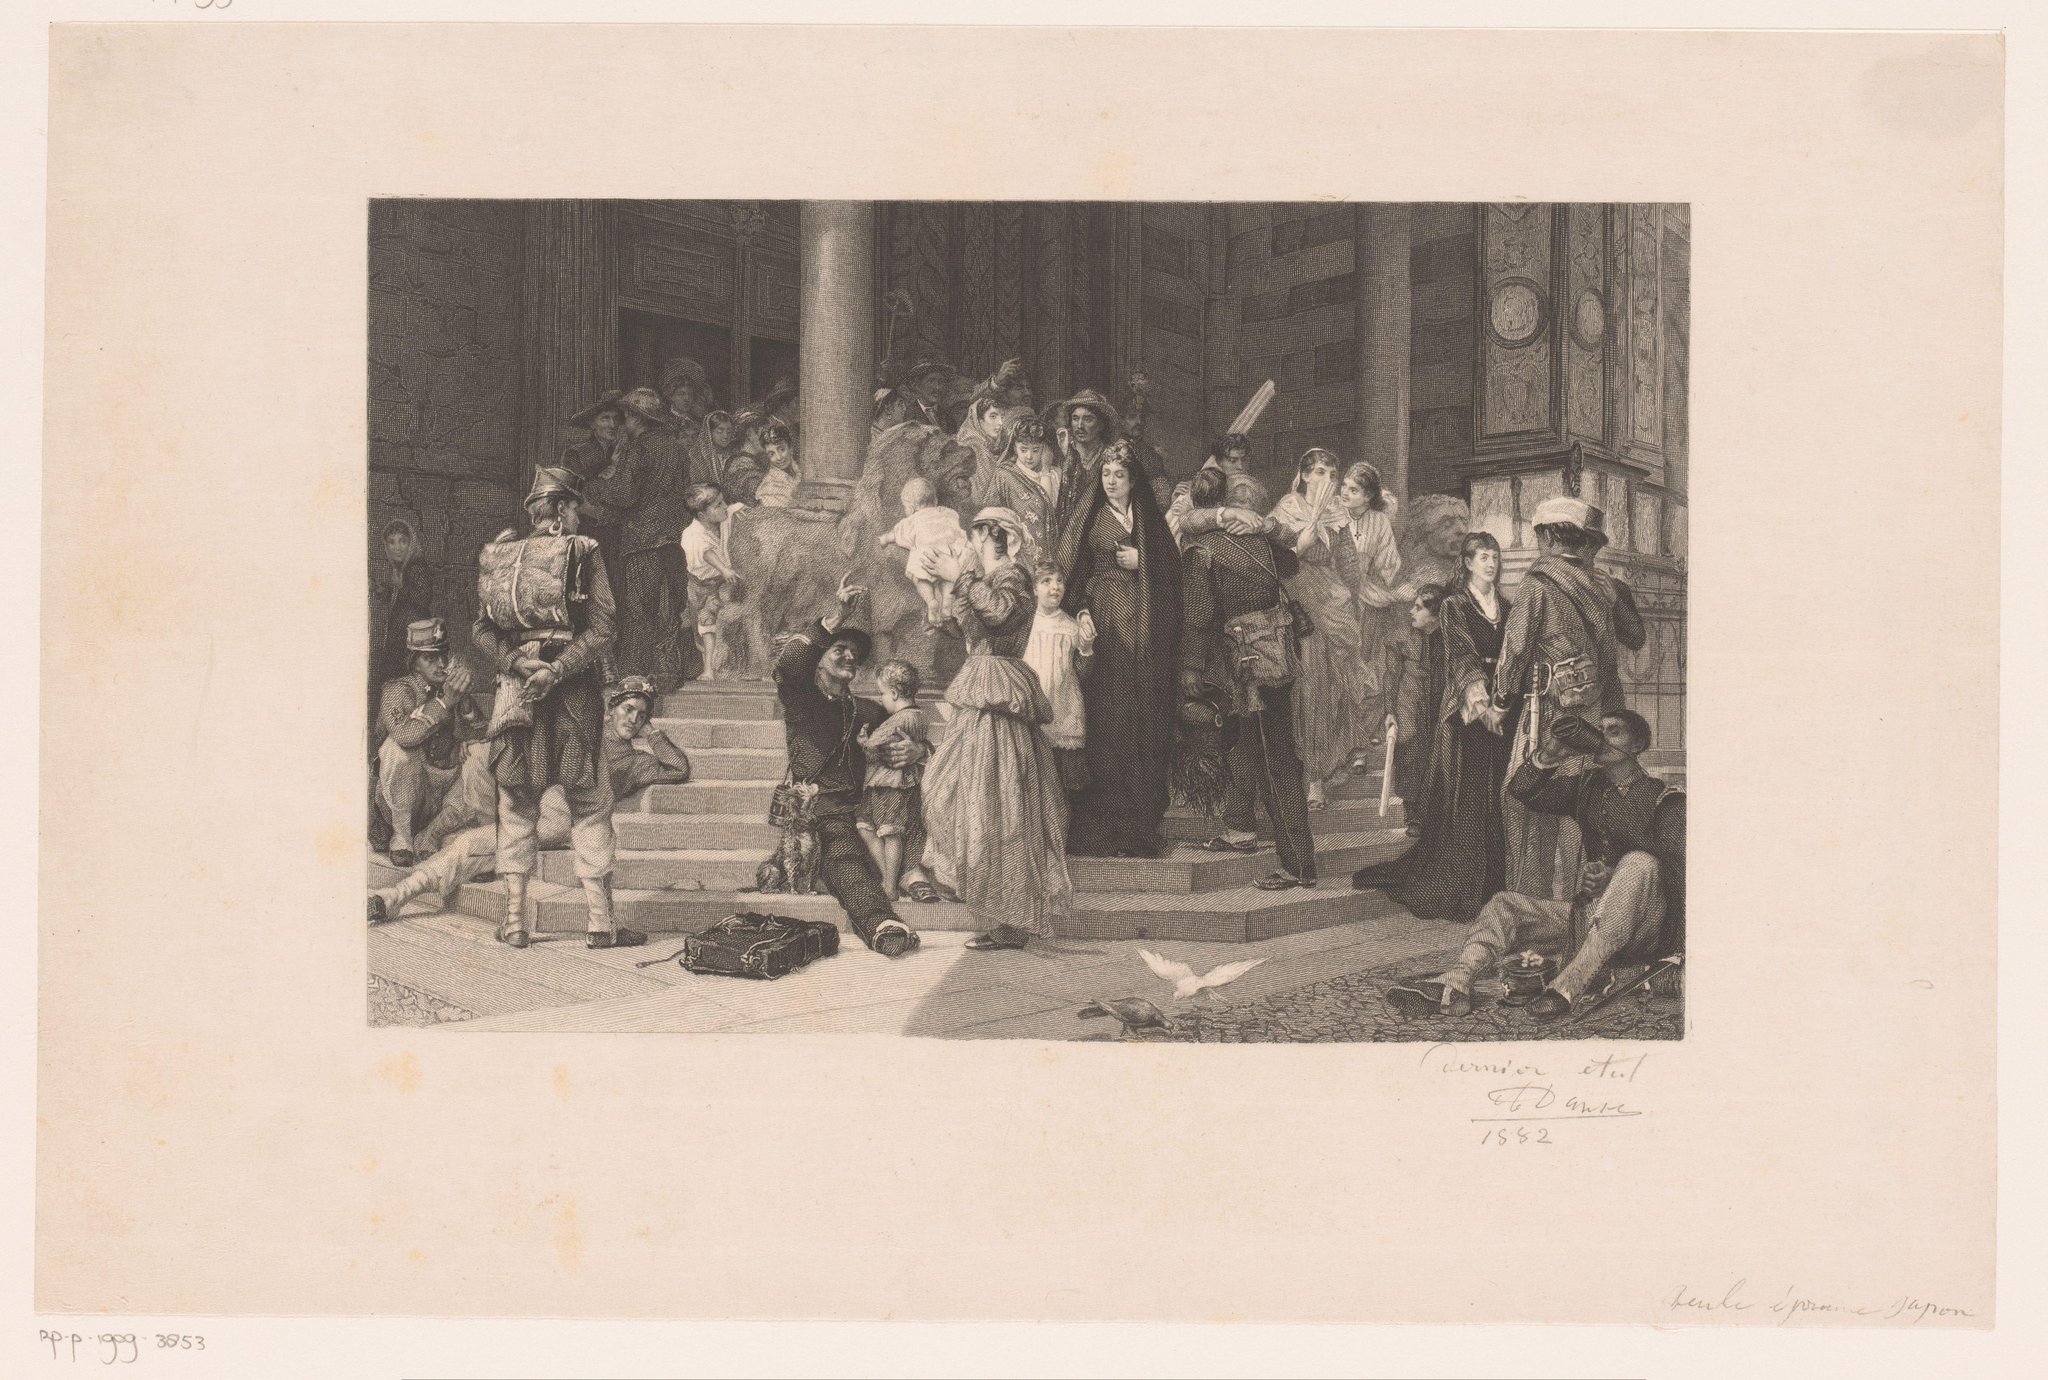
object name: print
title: Afscheid van de dienstplichtigen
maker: auguste danse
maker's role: print maker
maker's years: 1829-1929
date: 1882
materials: paper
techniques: engraving, etching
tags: conscription ~ enlisting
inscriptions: collector's mark: Lugt 2228, annotation: ‘dernier etat; seule épreuve Japon’